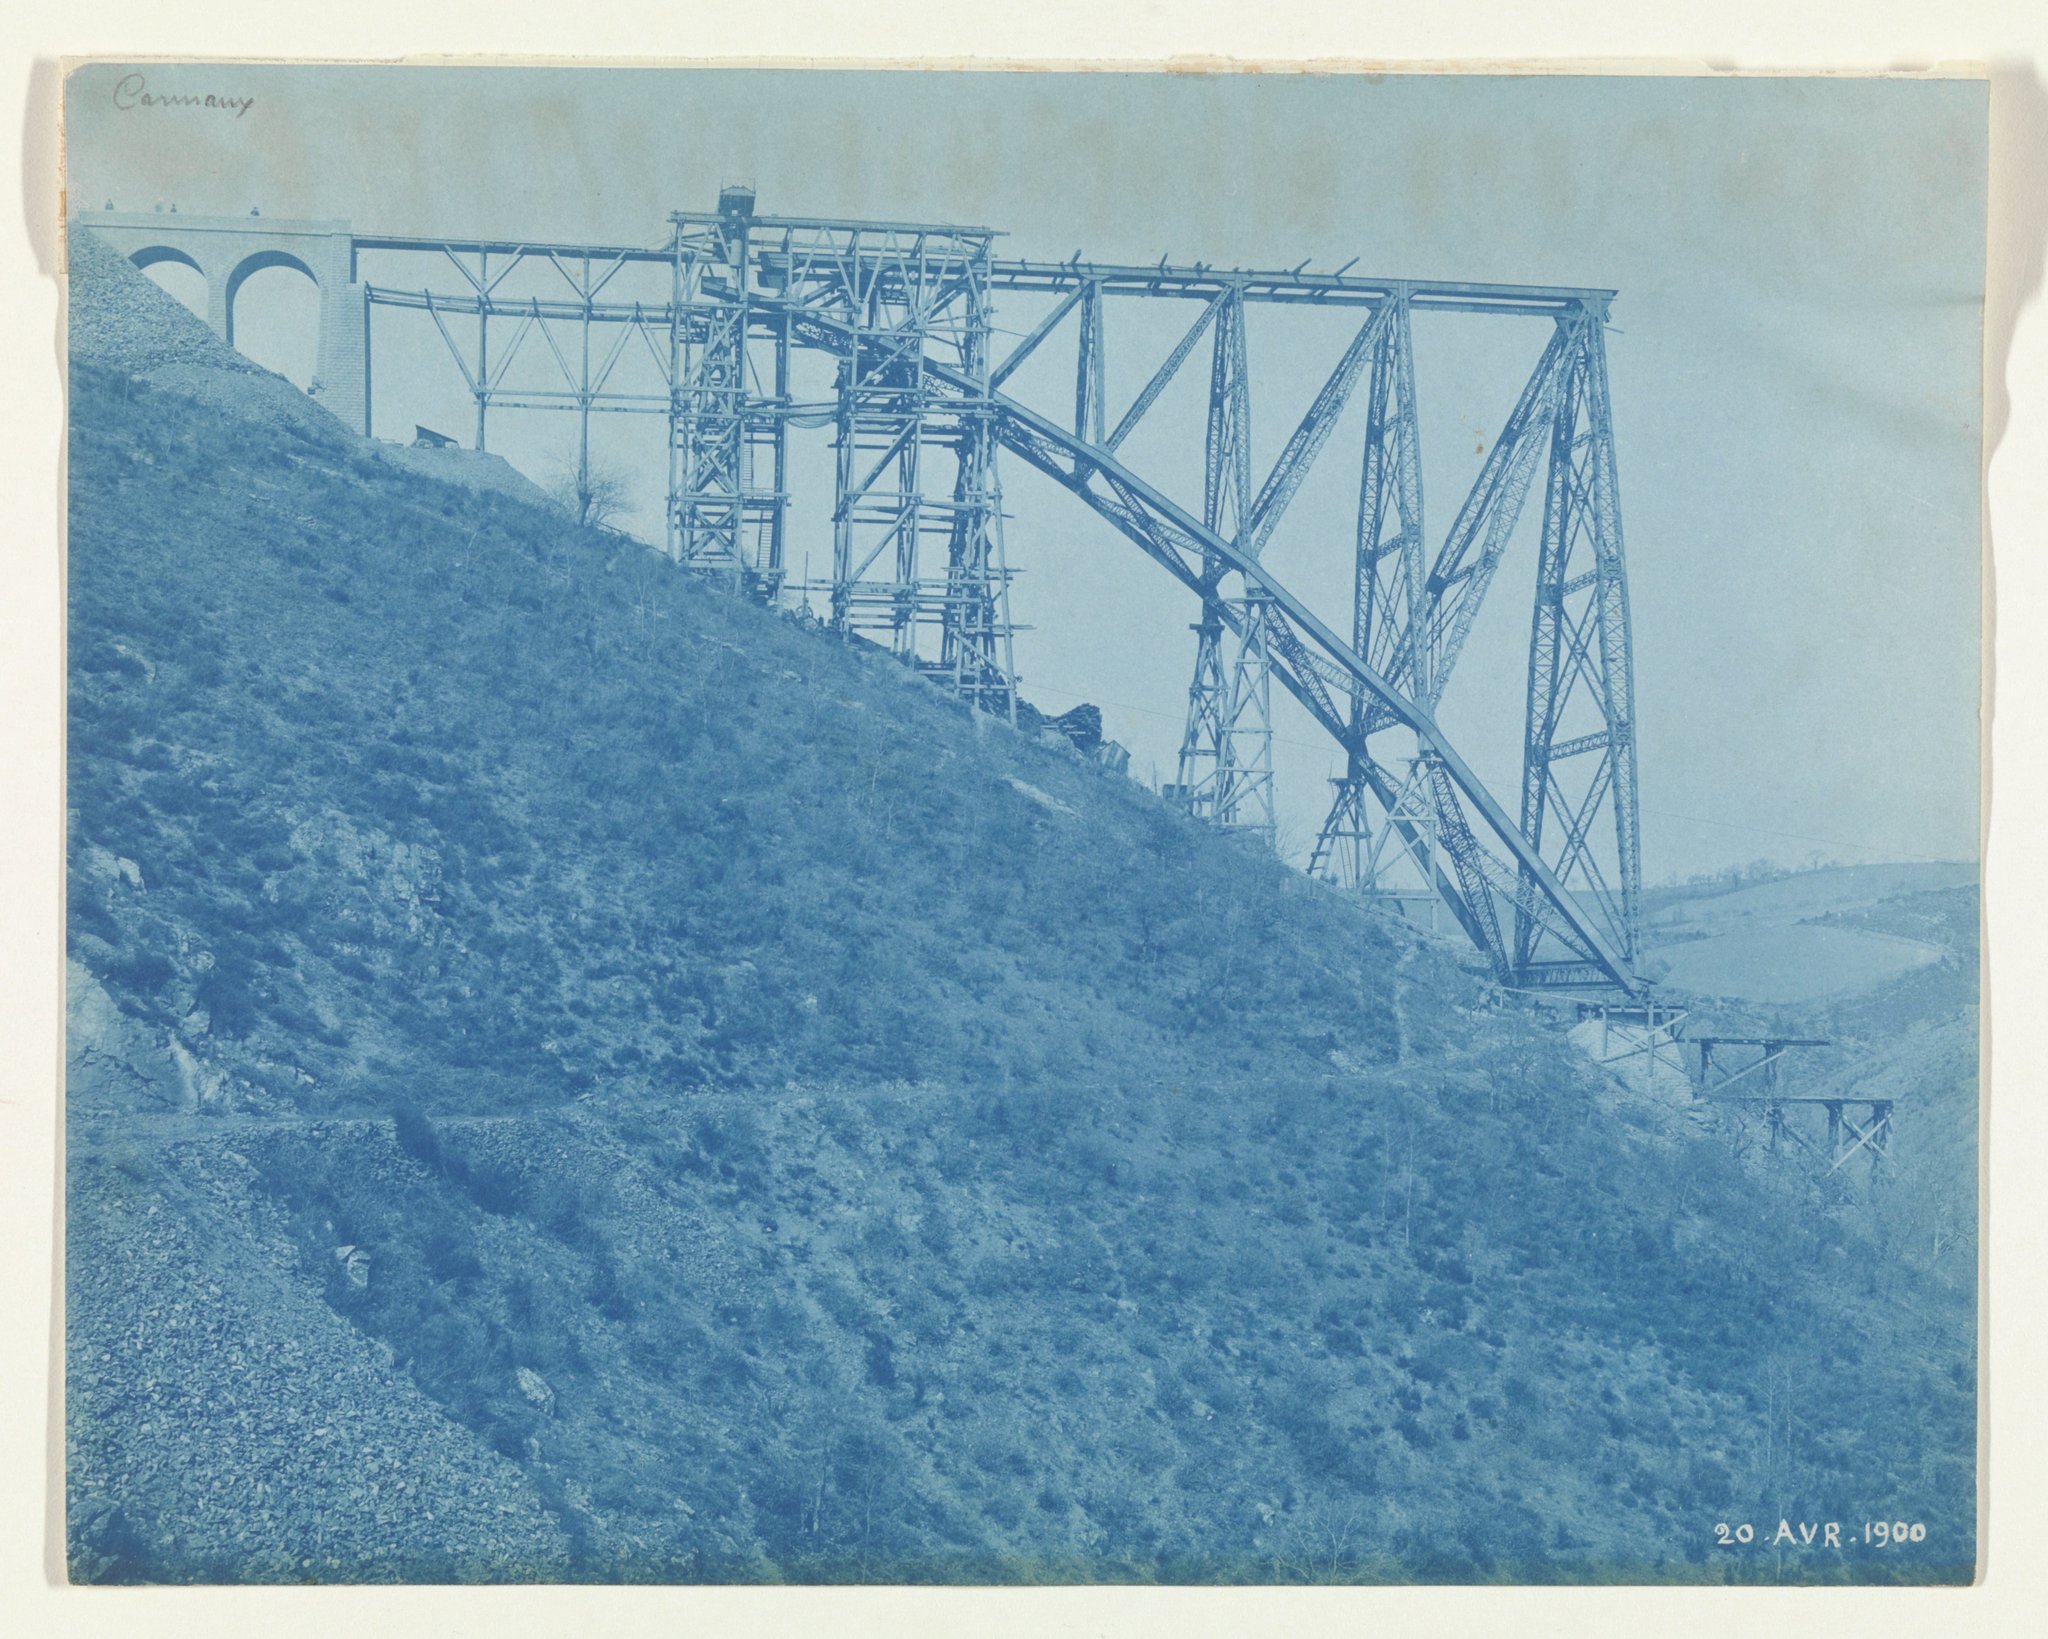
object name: photograph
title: Aanleg van het Viaur Viaduct in Frankrijk door de Societé de Construction des Battignolles, 20 april 1900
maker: Anonymous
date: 1900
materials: photographic support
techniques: cyanotype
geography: france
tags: viaduct, making the overground structures (~ building activities)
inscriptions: inscription: ‘Carmaux’